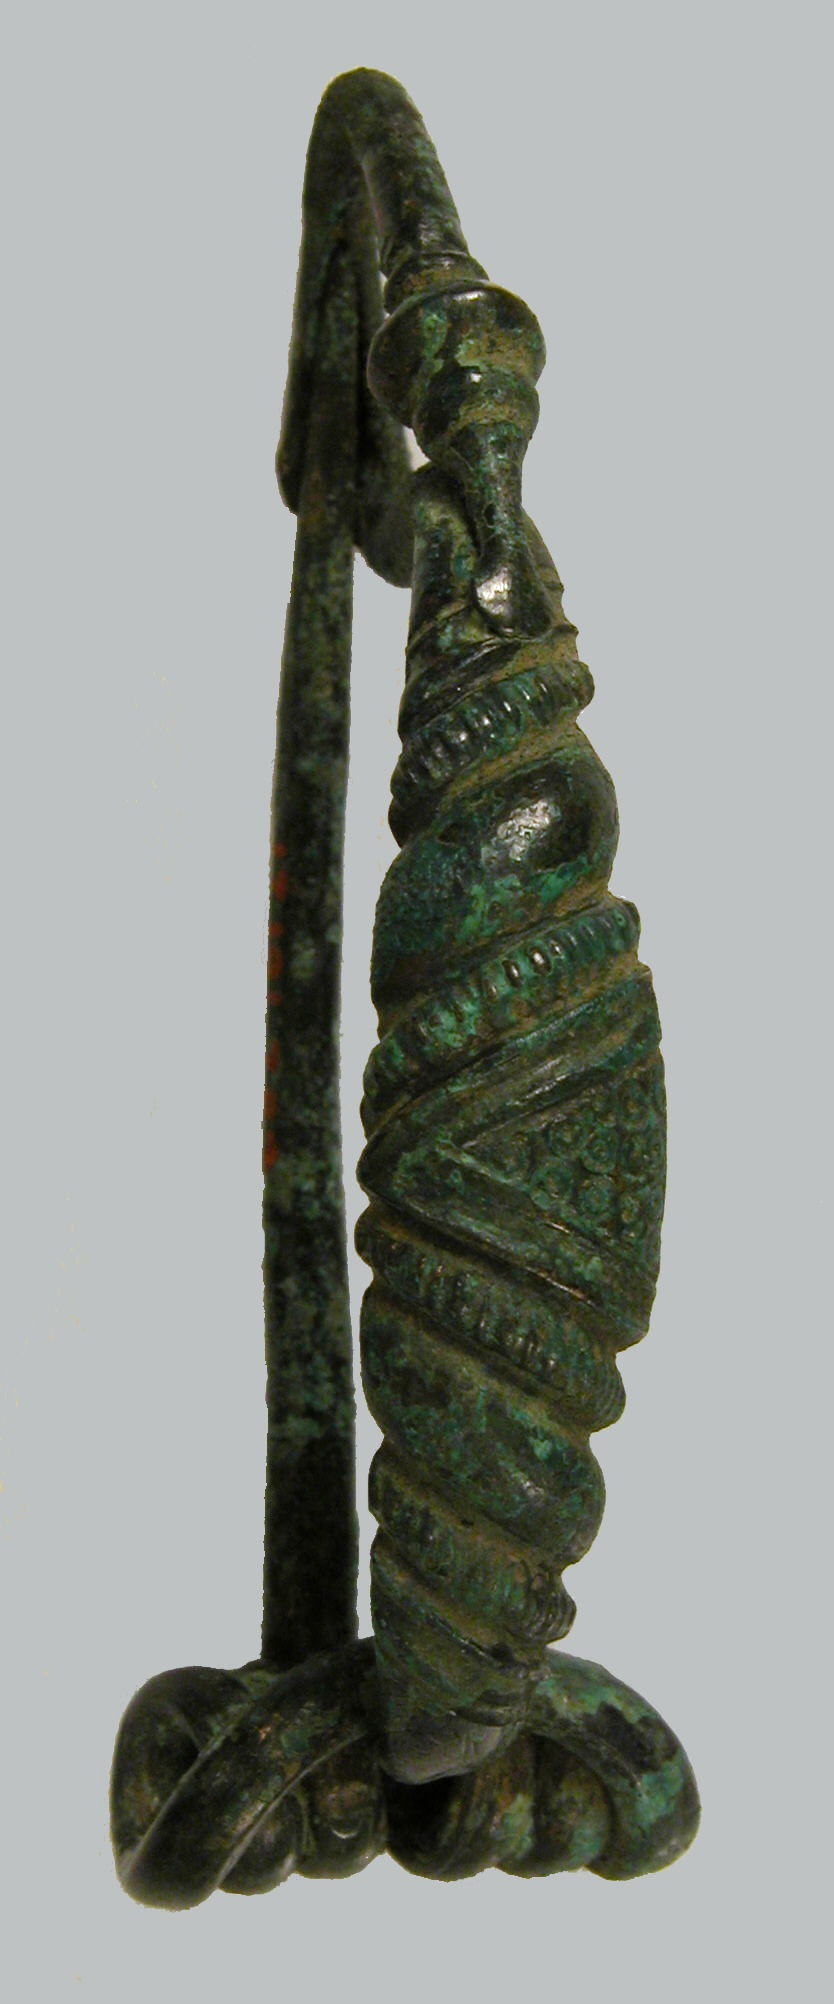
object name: brooch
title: Bow-Shaped Brooch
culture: celtic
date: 400-301 BCE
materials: copper alloy